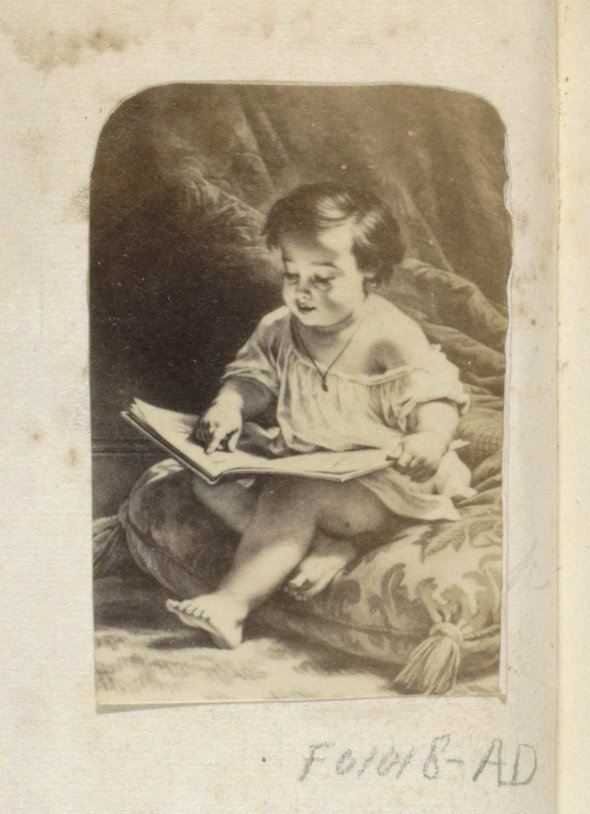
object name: reproduction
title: Fotoreproductie van (vermoedelijk) een schilderij van een lezend kind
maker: Anonymous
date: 1860-1870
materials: paper, photographic support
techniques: albumen print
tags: reading, child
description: Onderdeel van Engels familiealbum met foto's van personen, reizen, cricket en kunstwerken.